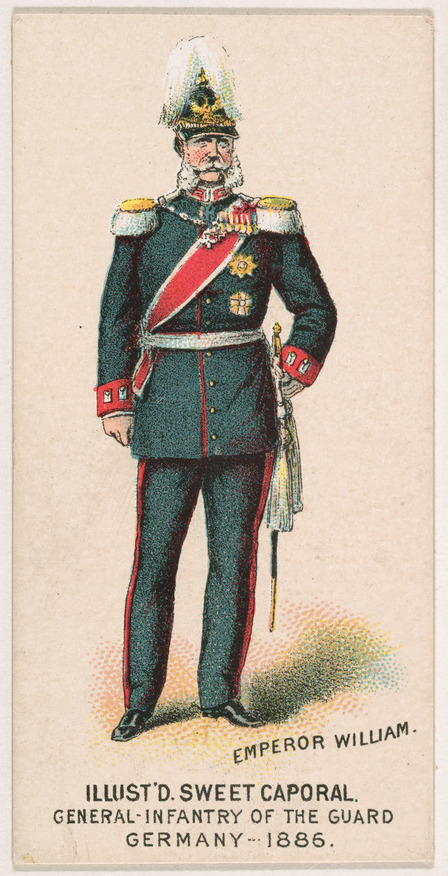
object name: print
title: General, Infantry of the Guard, Germany, 1886, from the Military Series (N224) issued by Kinney Tobacco Company to promote Sweet Caporal Cigarettes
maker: kinney brothers tobacco company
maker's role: publisher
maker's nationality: american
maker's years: 1869-2011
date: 1888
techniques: color lithograph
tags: soldiers,men